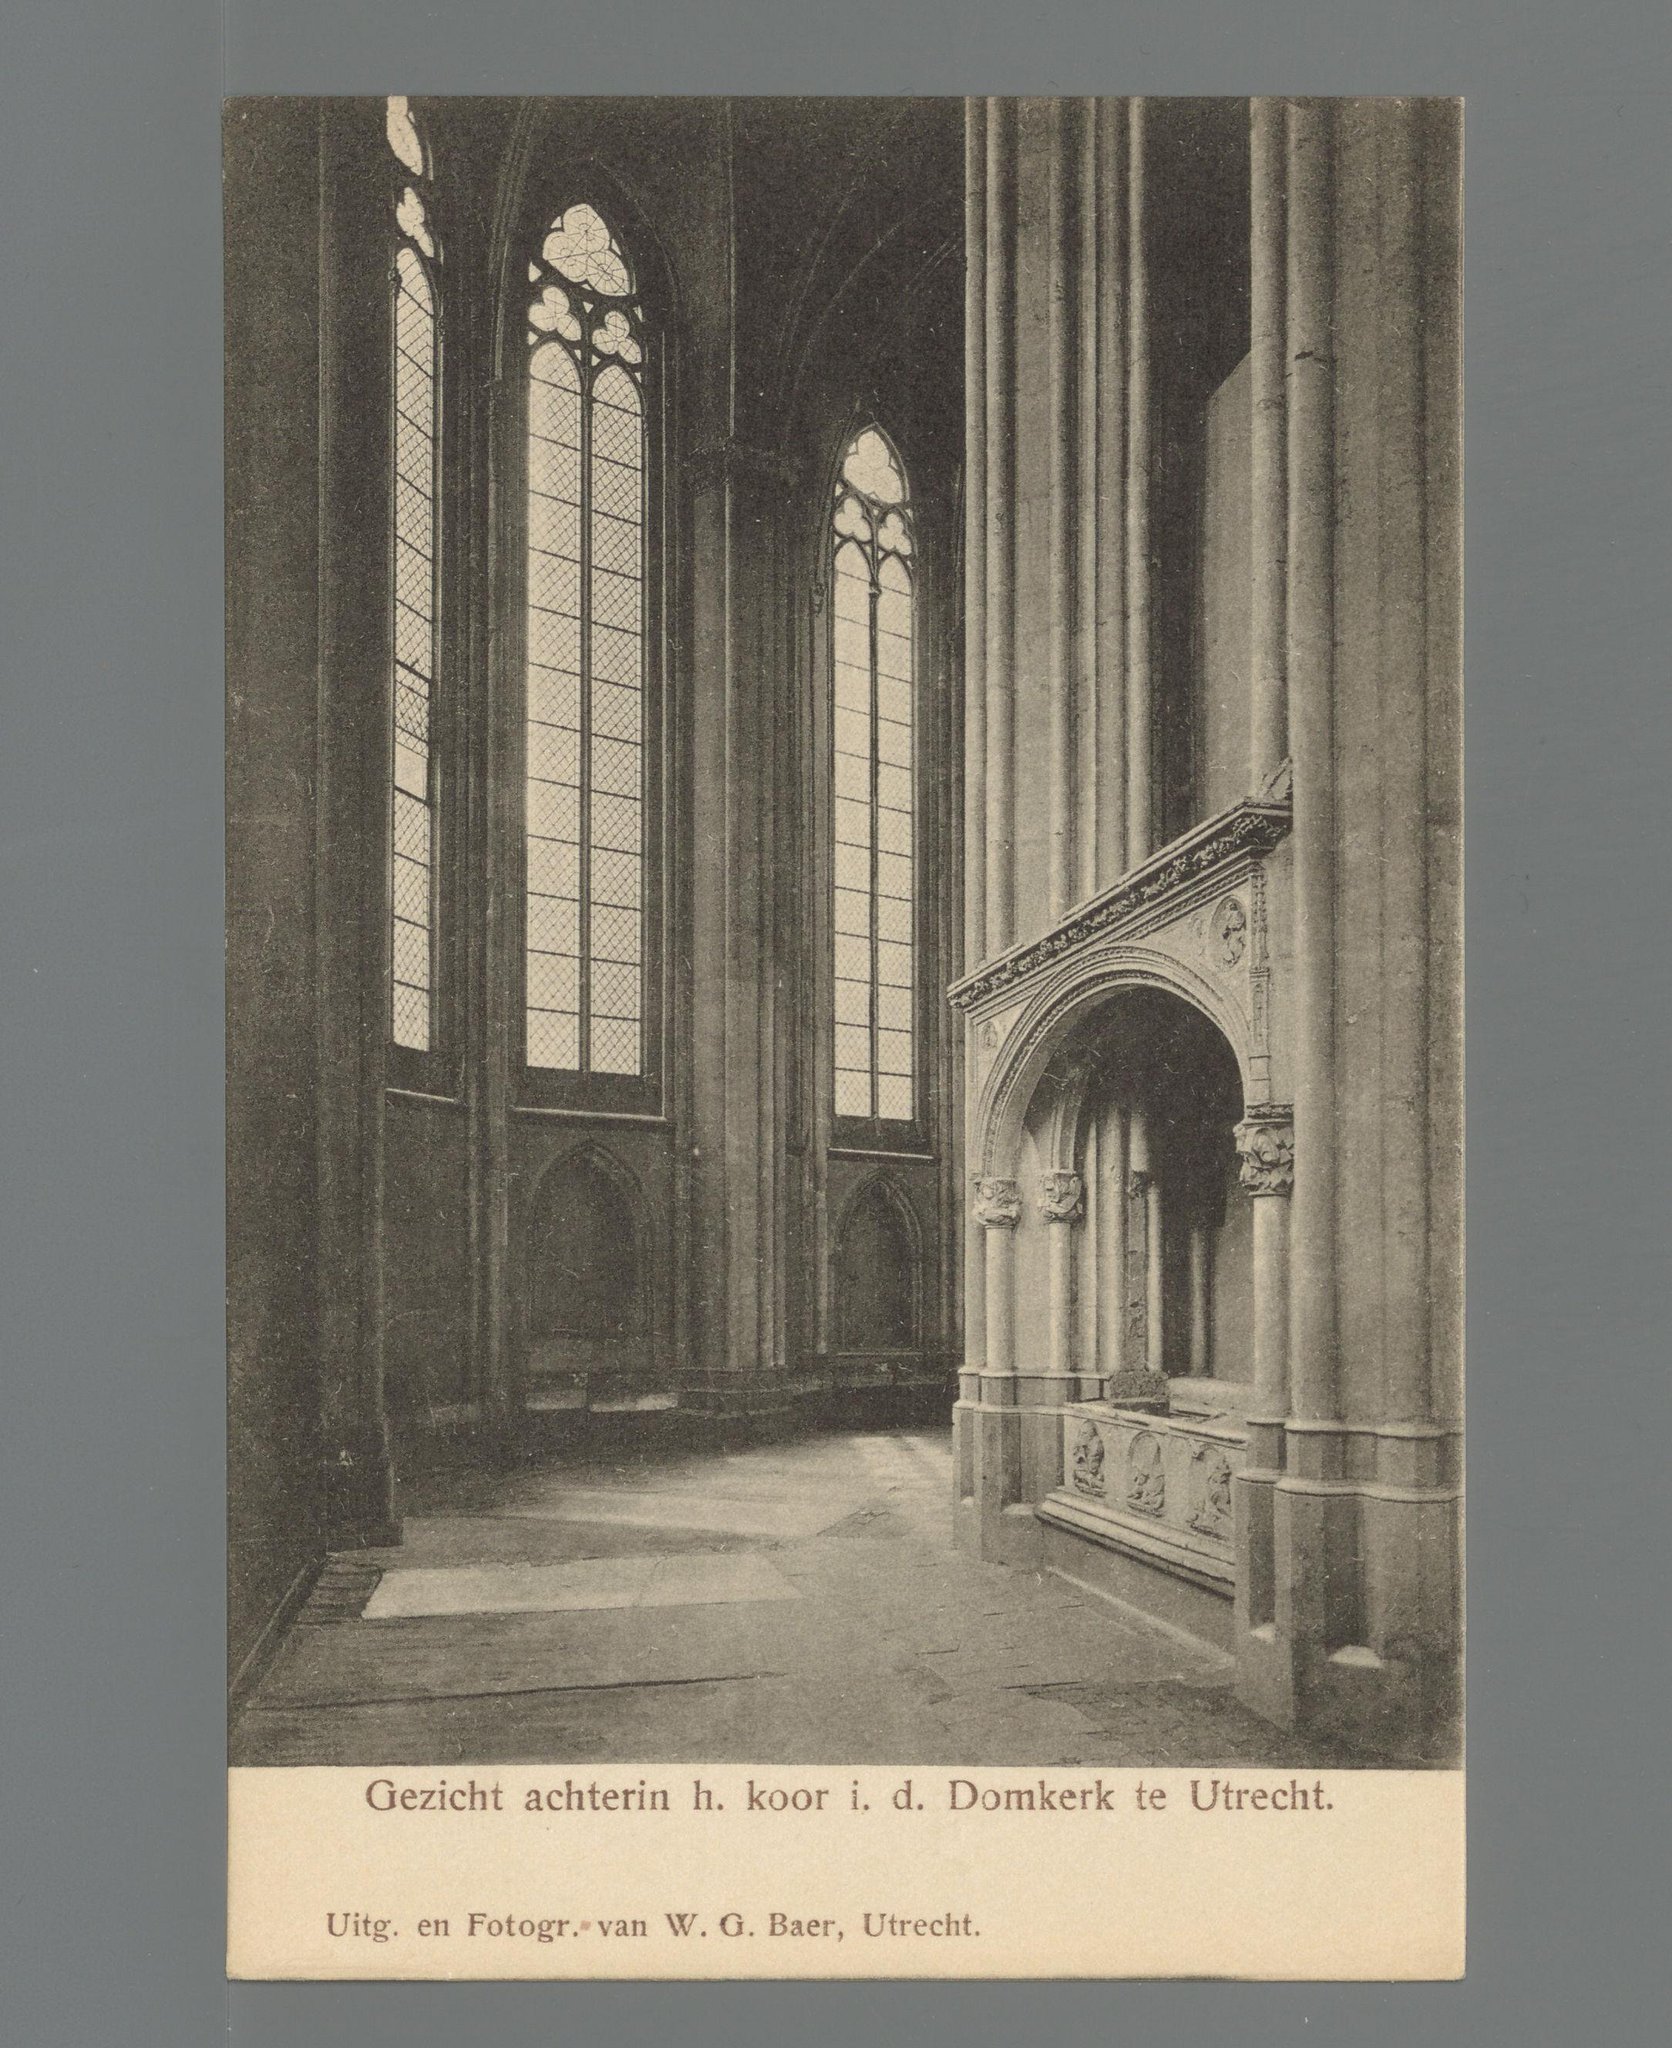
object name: photomechanical print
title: Gezicht achterin h. koor i. d. Domkerk te Utrecht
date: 1897-1905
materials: cardboard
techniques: photograph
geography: utrecht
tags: parts of church exterior and annexes: choir, interior of church